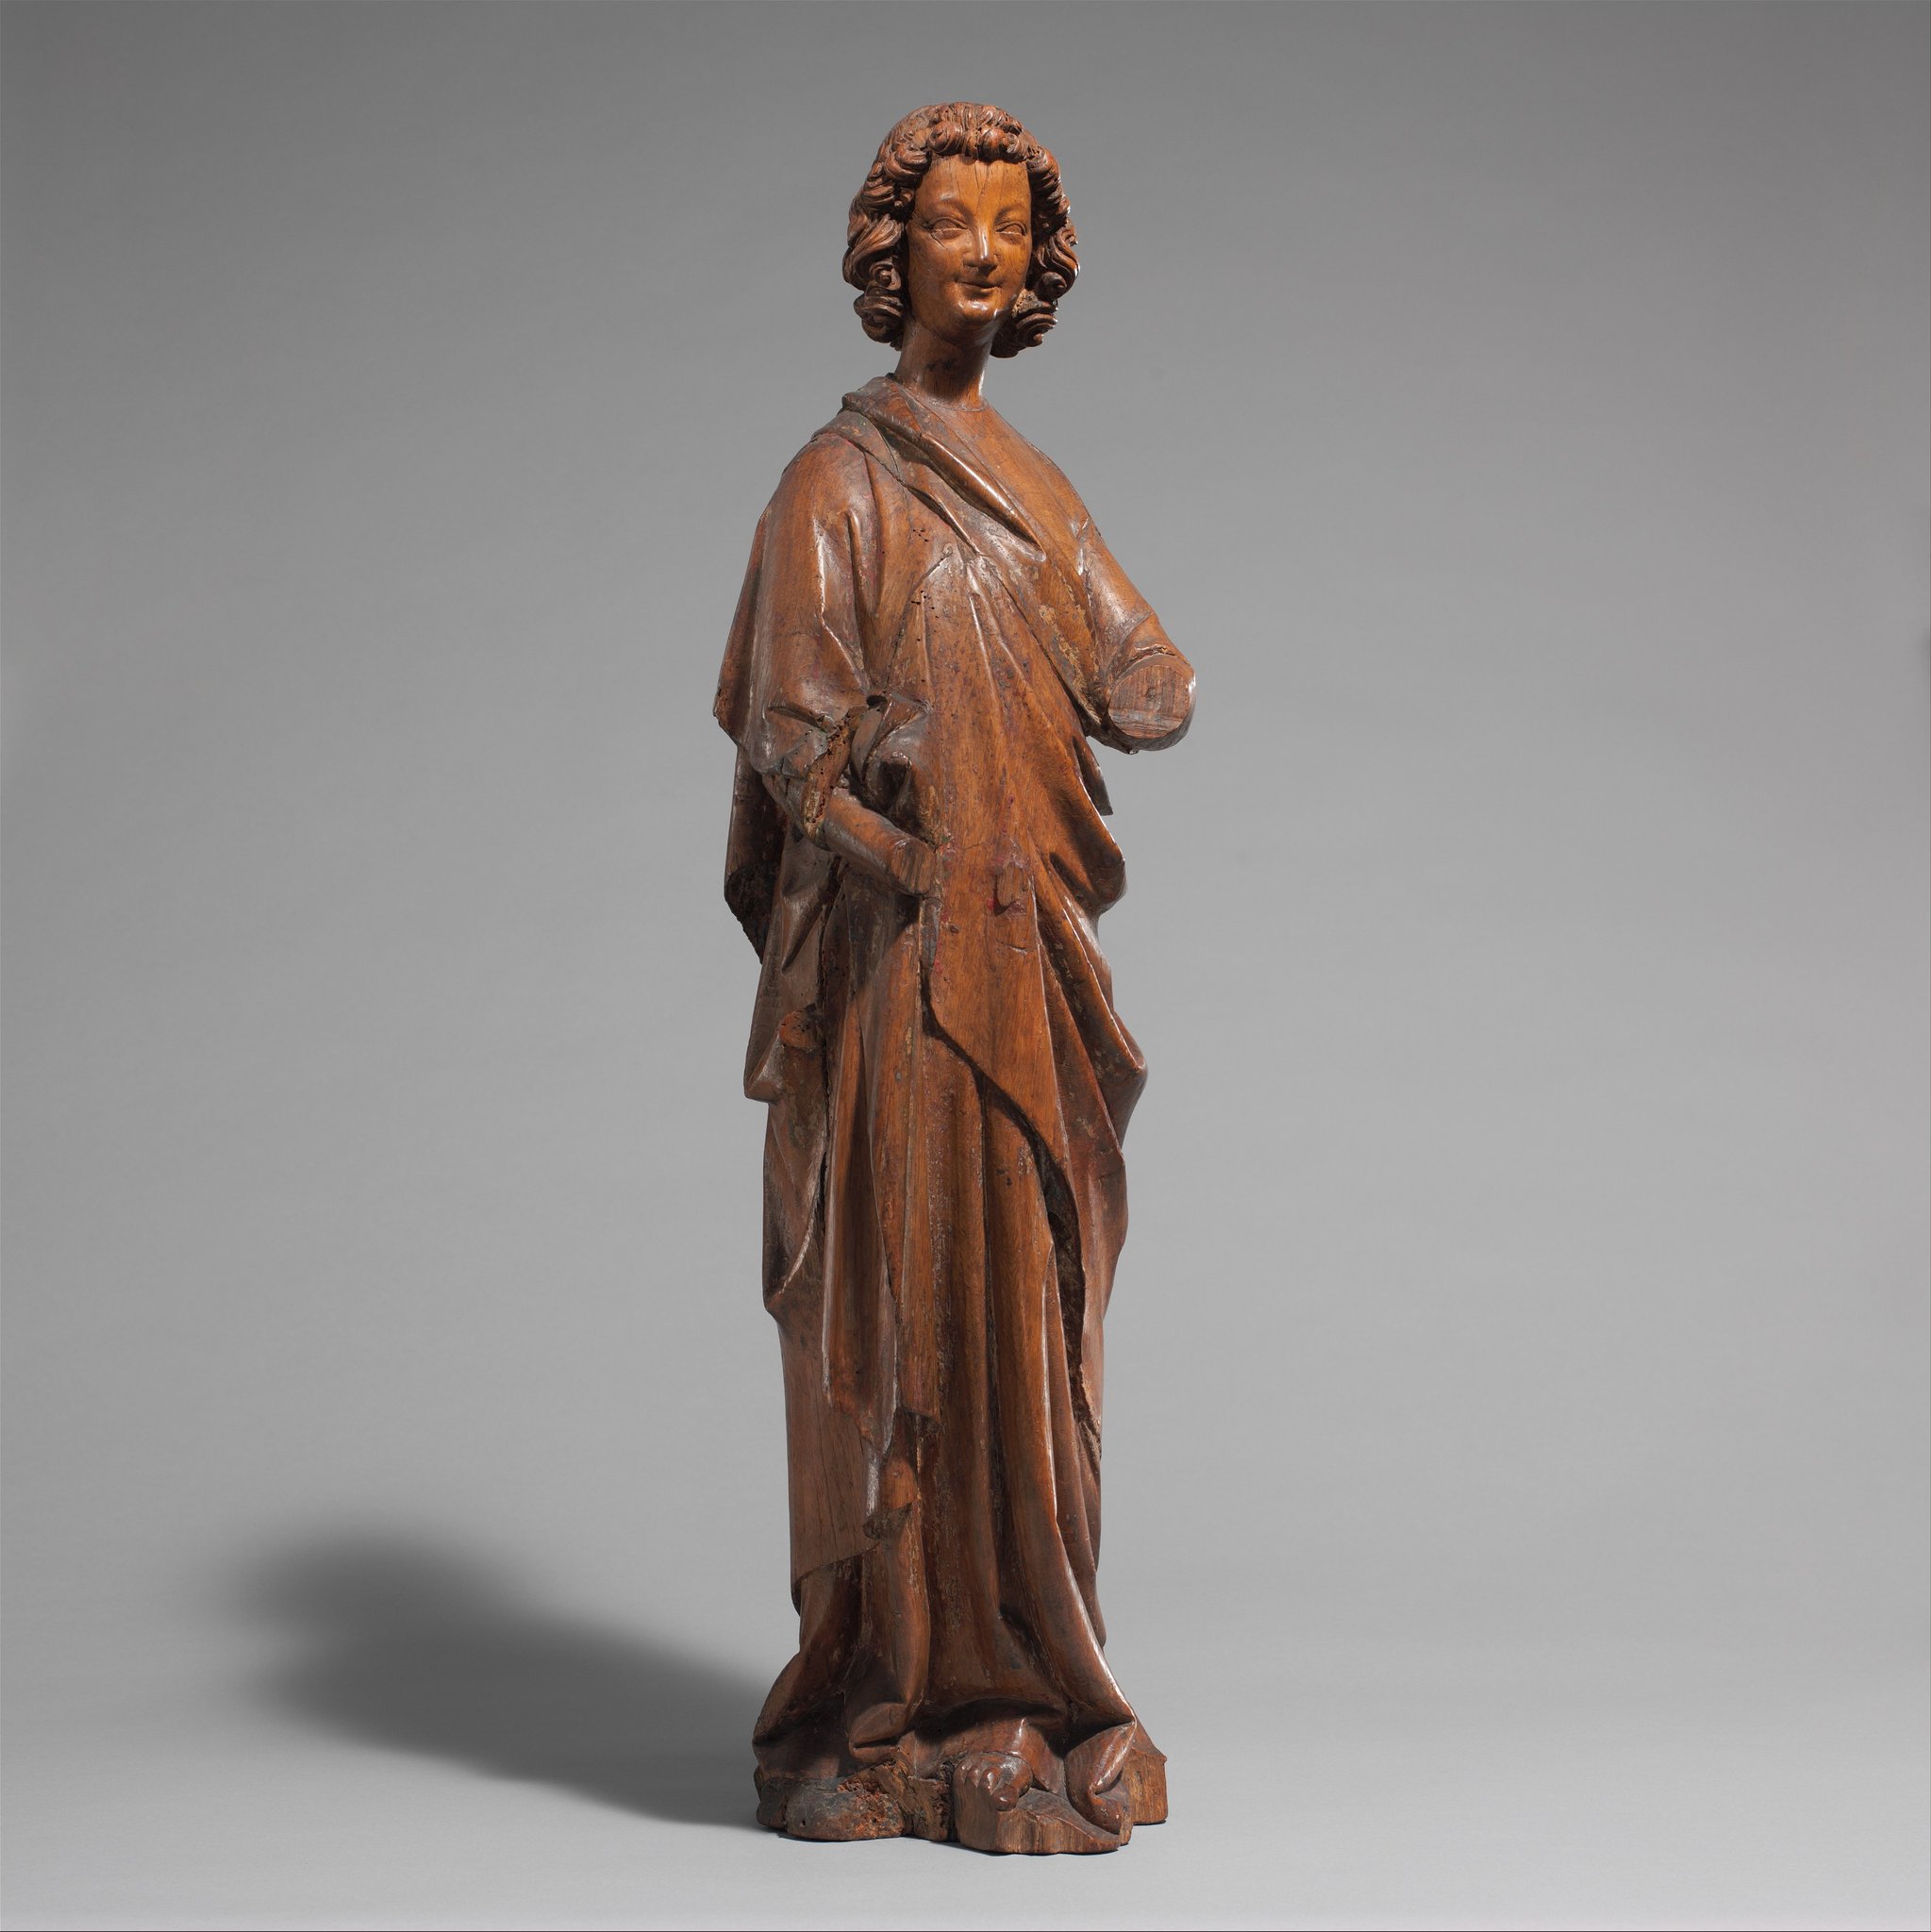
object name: statuette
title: Altar Angel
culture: french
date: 1275-1300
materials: wood, paint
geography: france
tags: angels